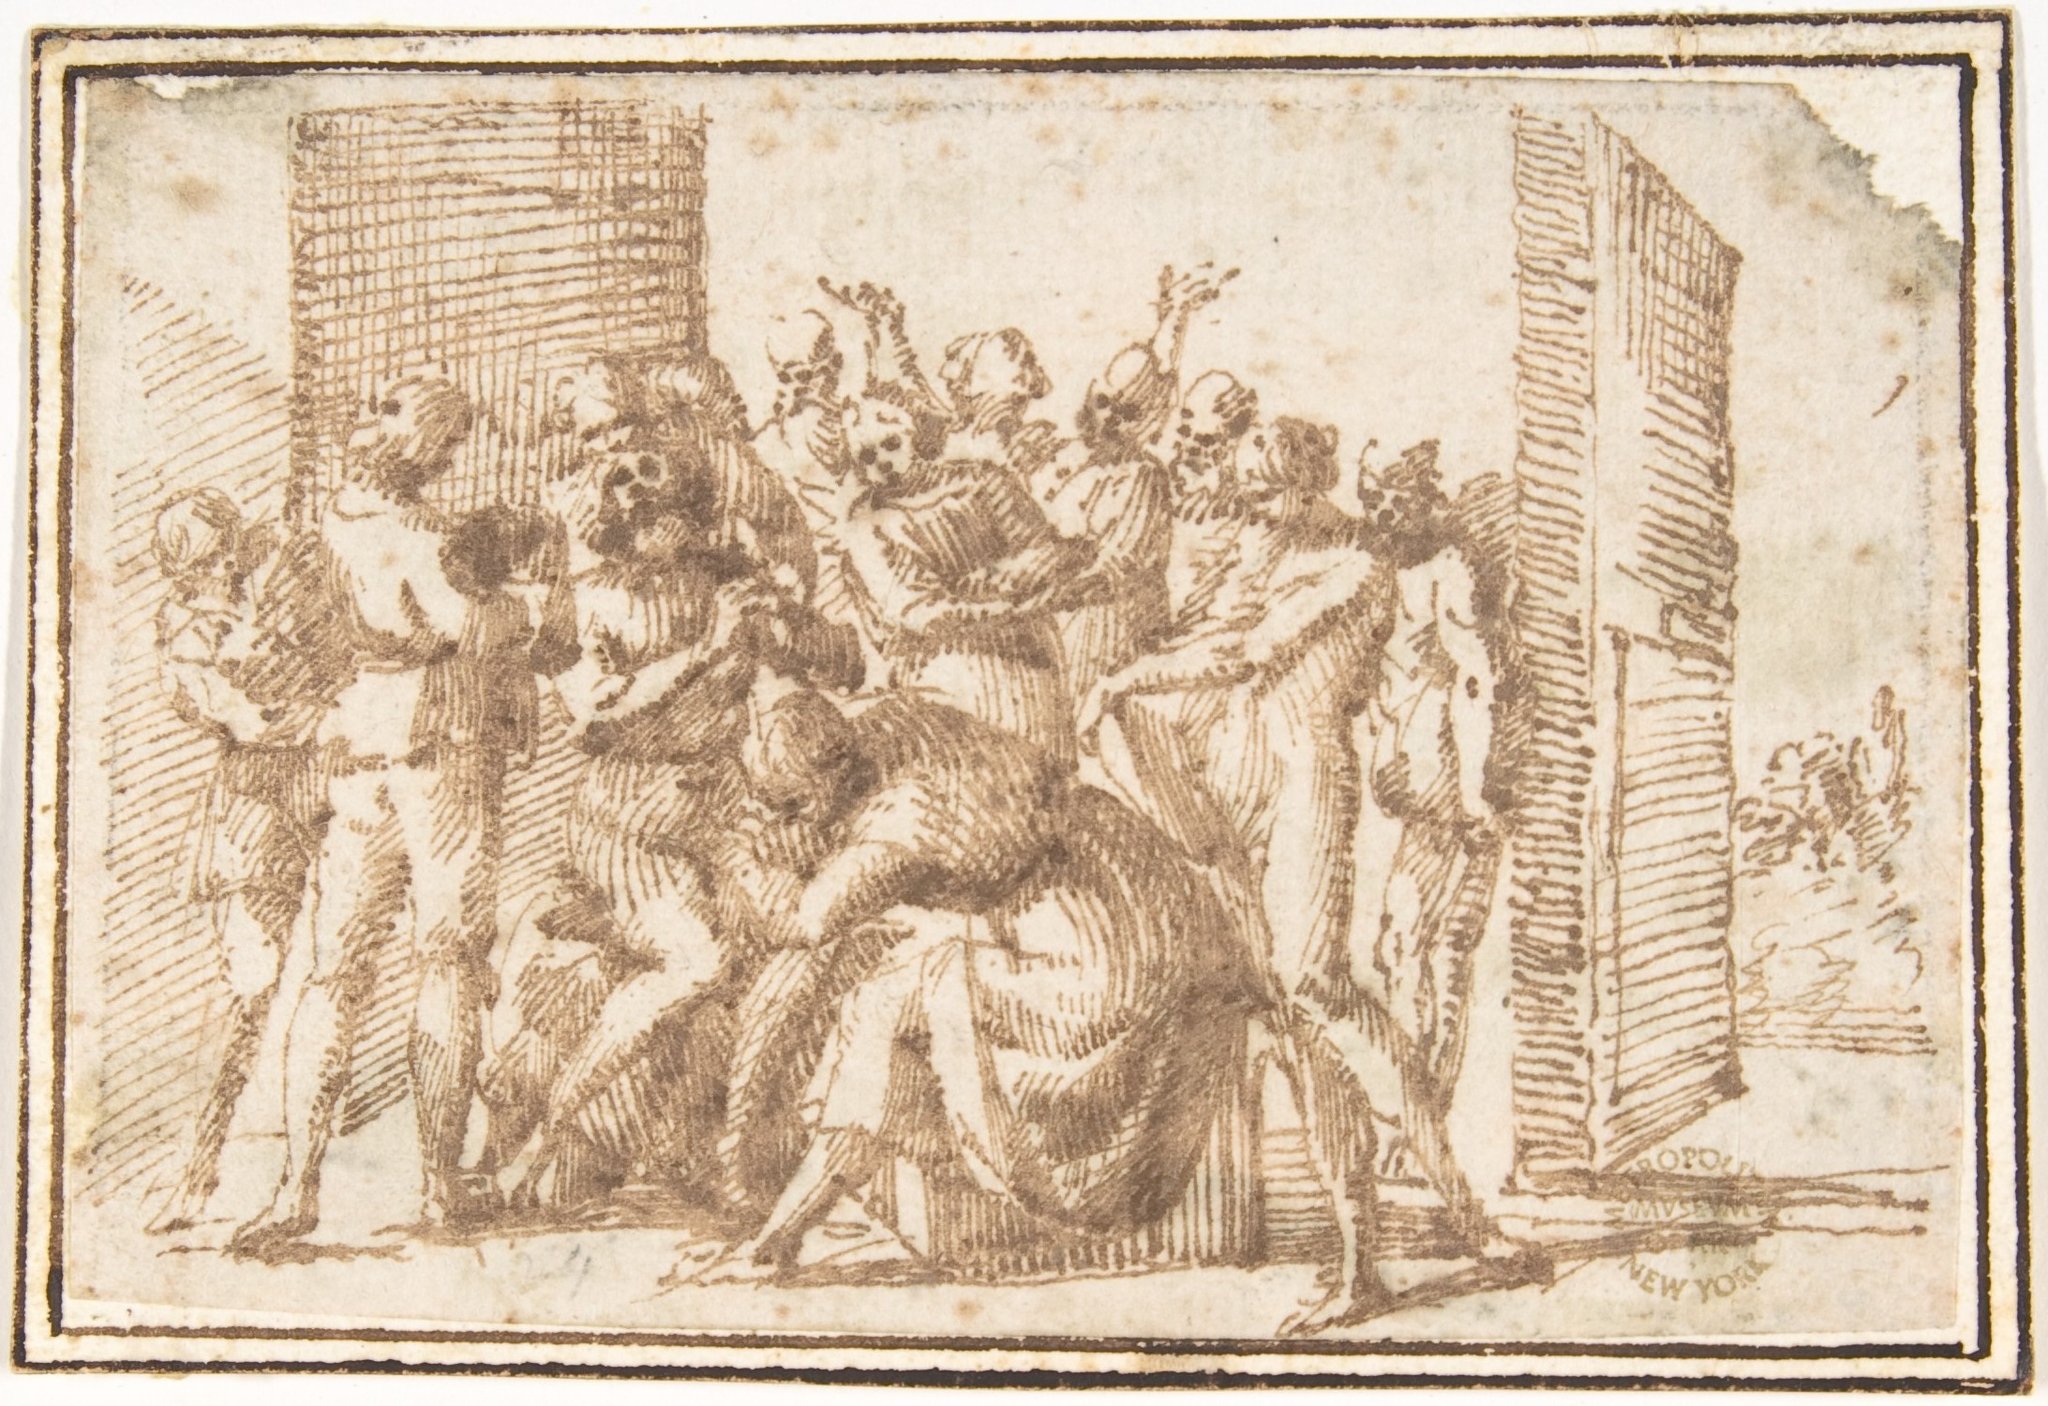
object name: drawing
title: Religious Scene (Job and His Comforters?)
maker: francesco allegrini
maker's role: artist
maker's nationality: italian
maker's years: 1615-1679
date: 1624-1663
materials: chalk, ink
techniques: pen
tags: men